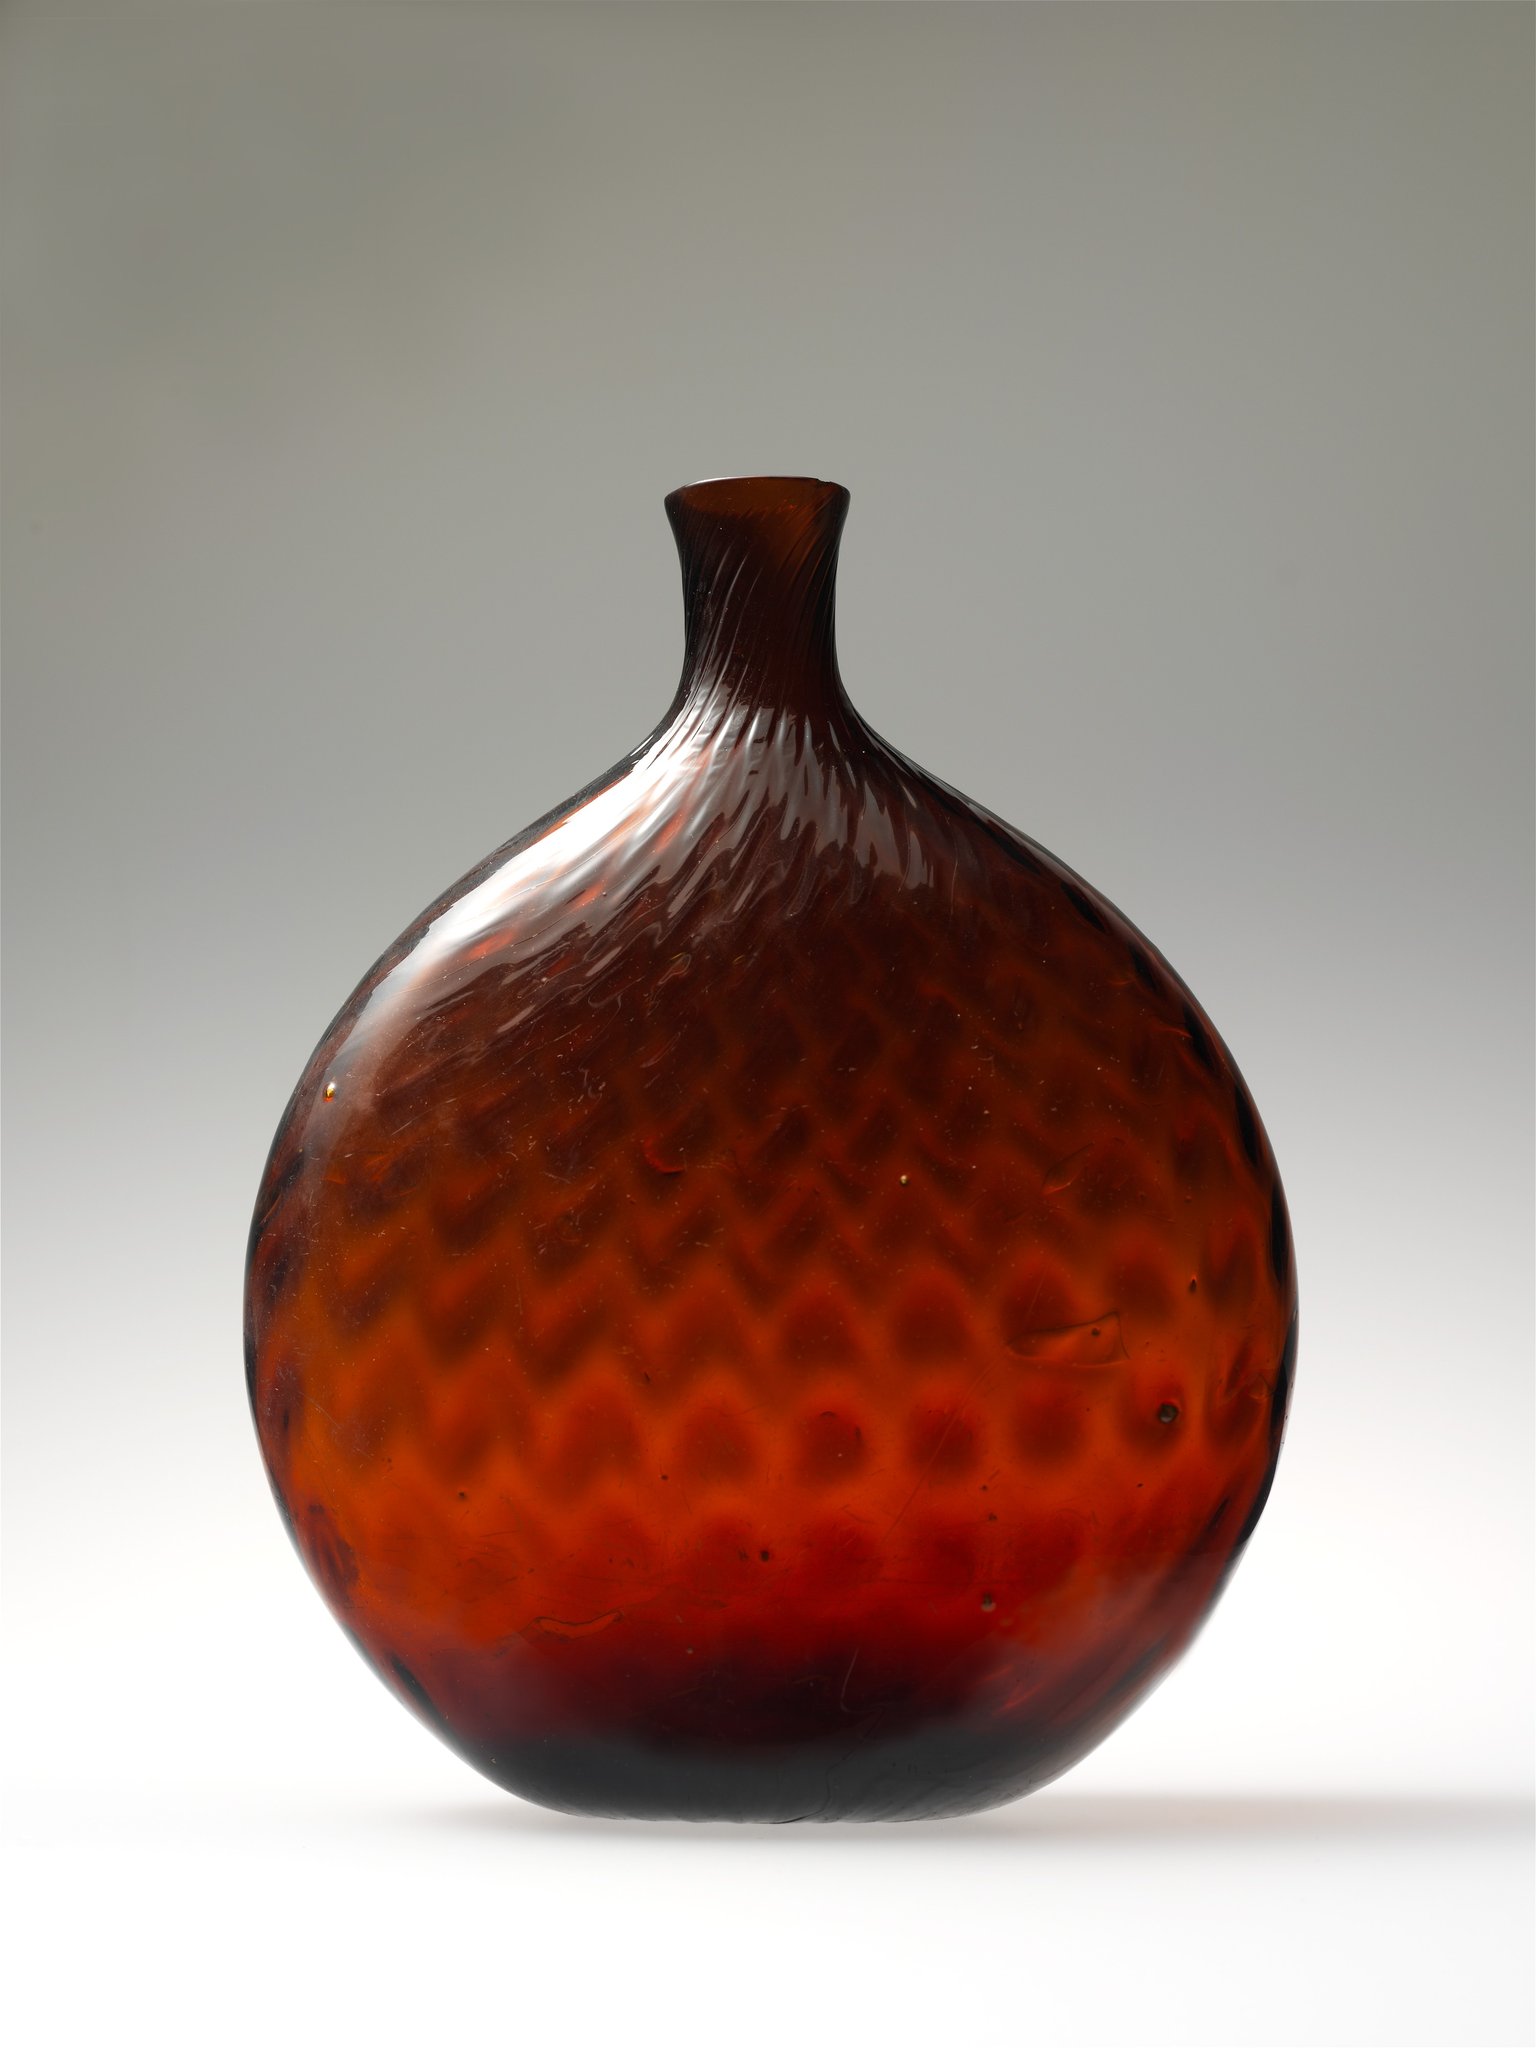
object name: pocket bottle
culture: american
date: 1815-1845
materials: glass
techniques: glassblowing, molding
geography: united states